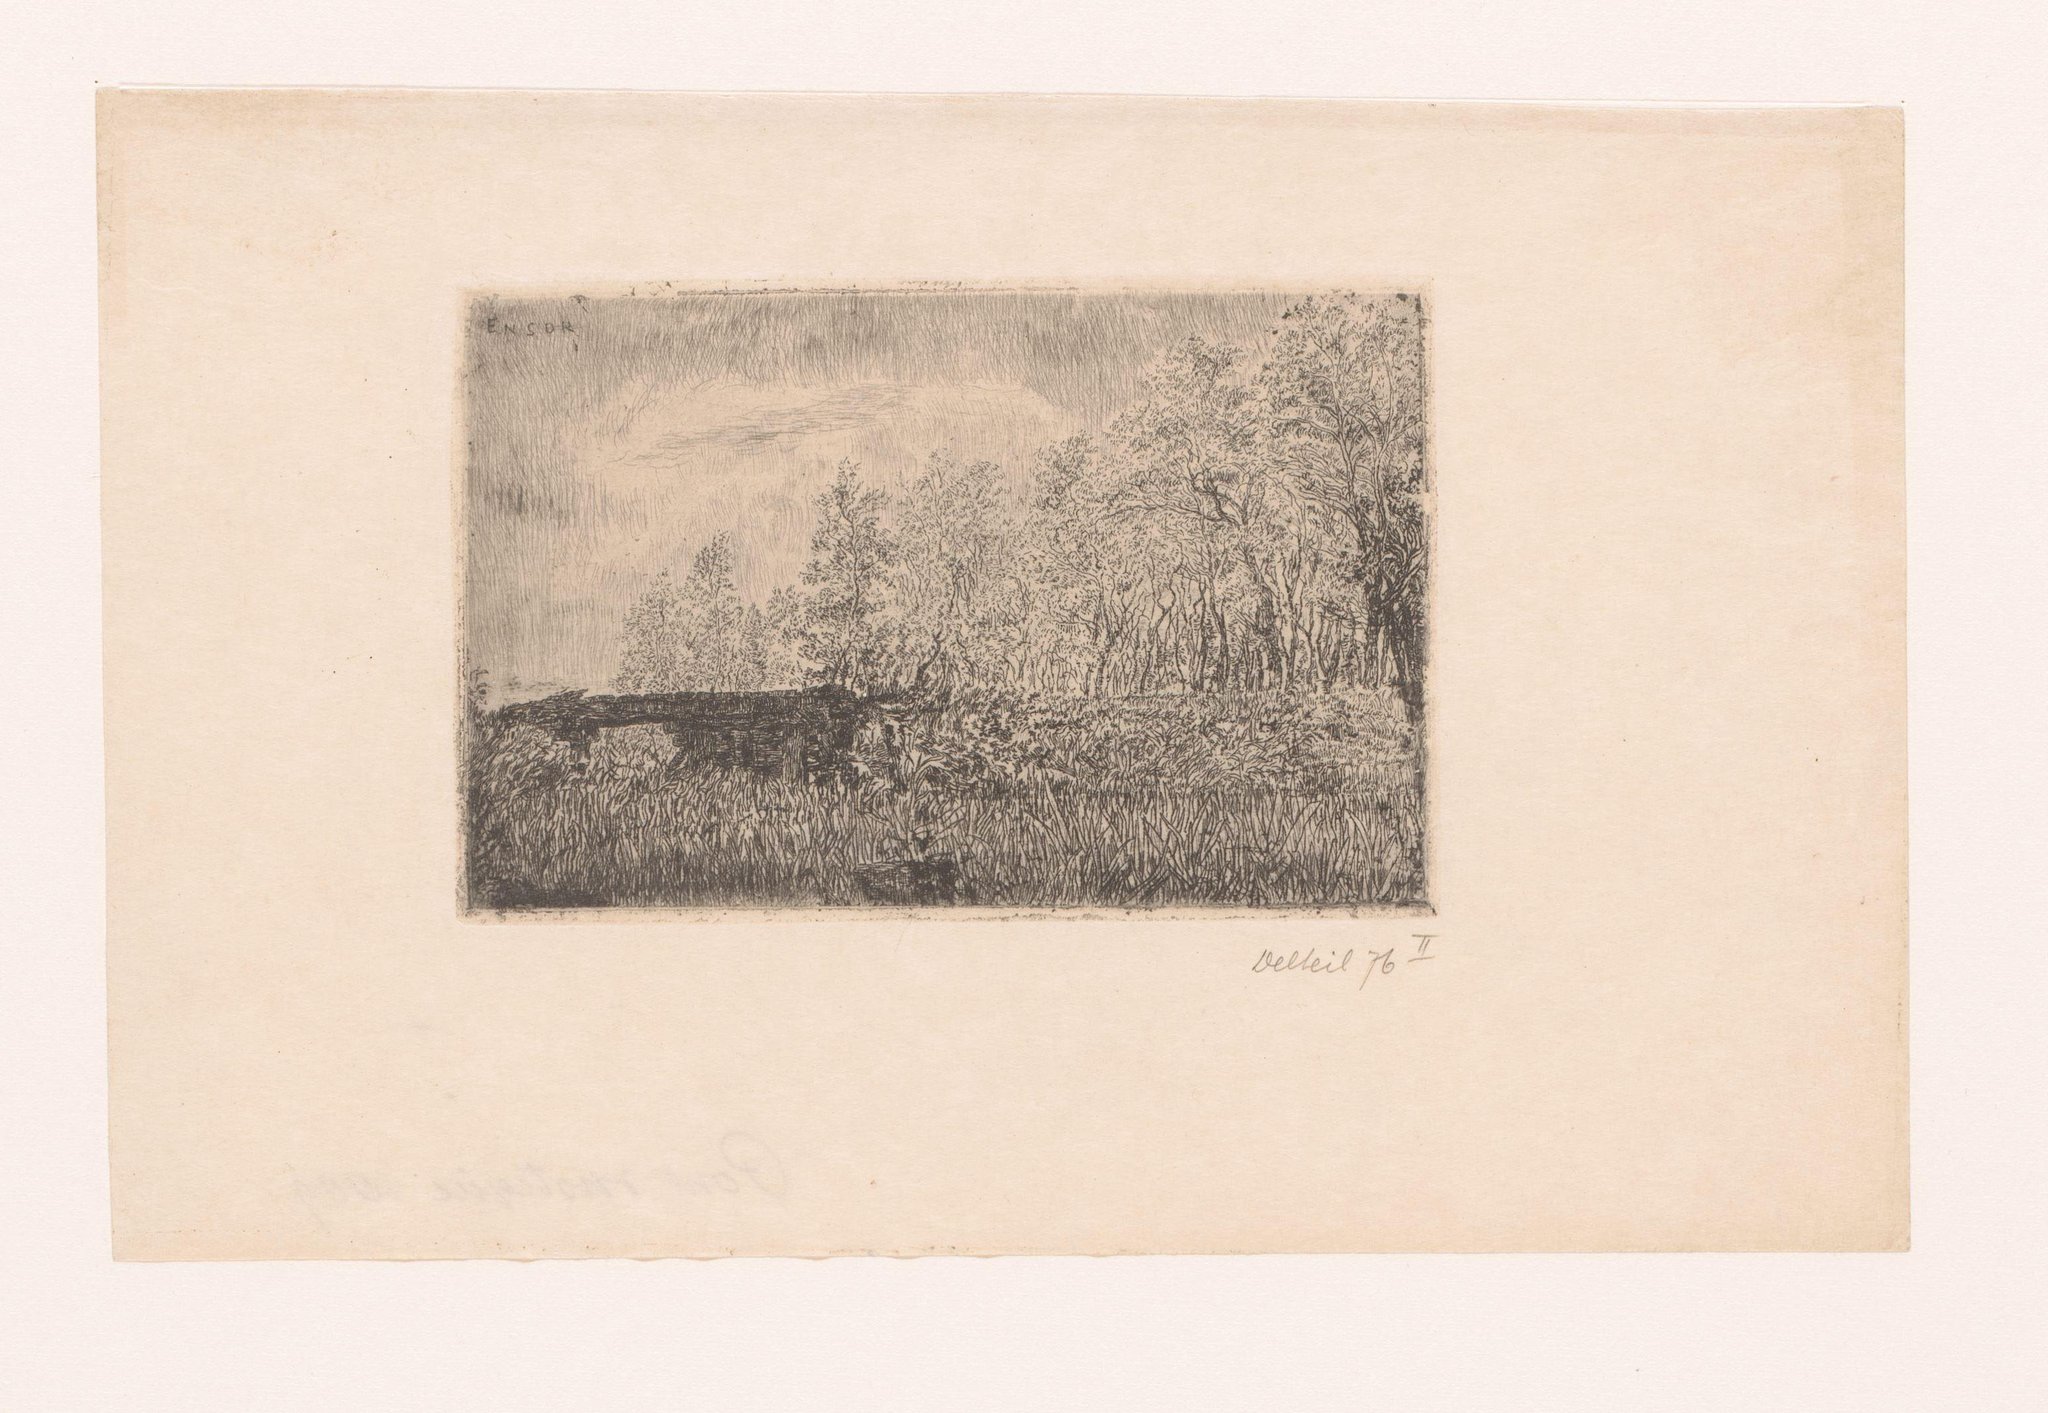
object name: print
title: Landschap met brug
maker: james ensor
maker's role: print maker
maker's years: 1860-1949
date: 1889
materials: paper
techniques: drypoint, etching, intaglio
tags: landscape with bridge, viaduct or aqueduct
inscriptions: collector's mark: Lugt 2228